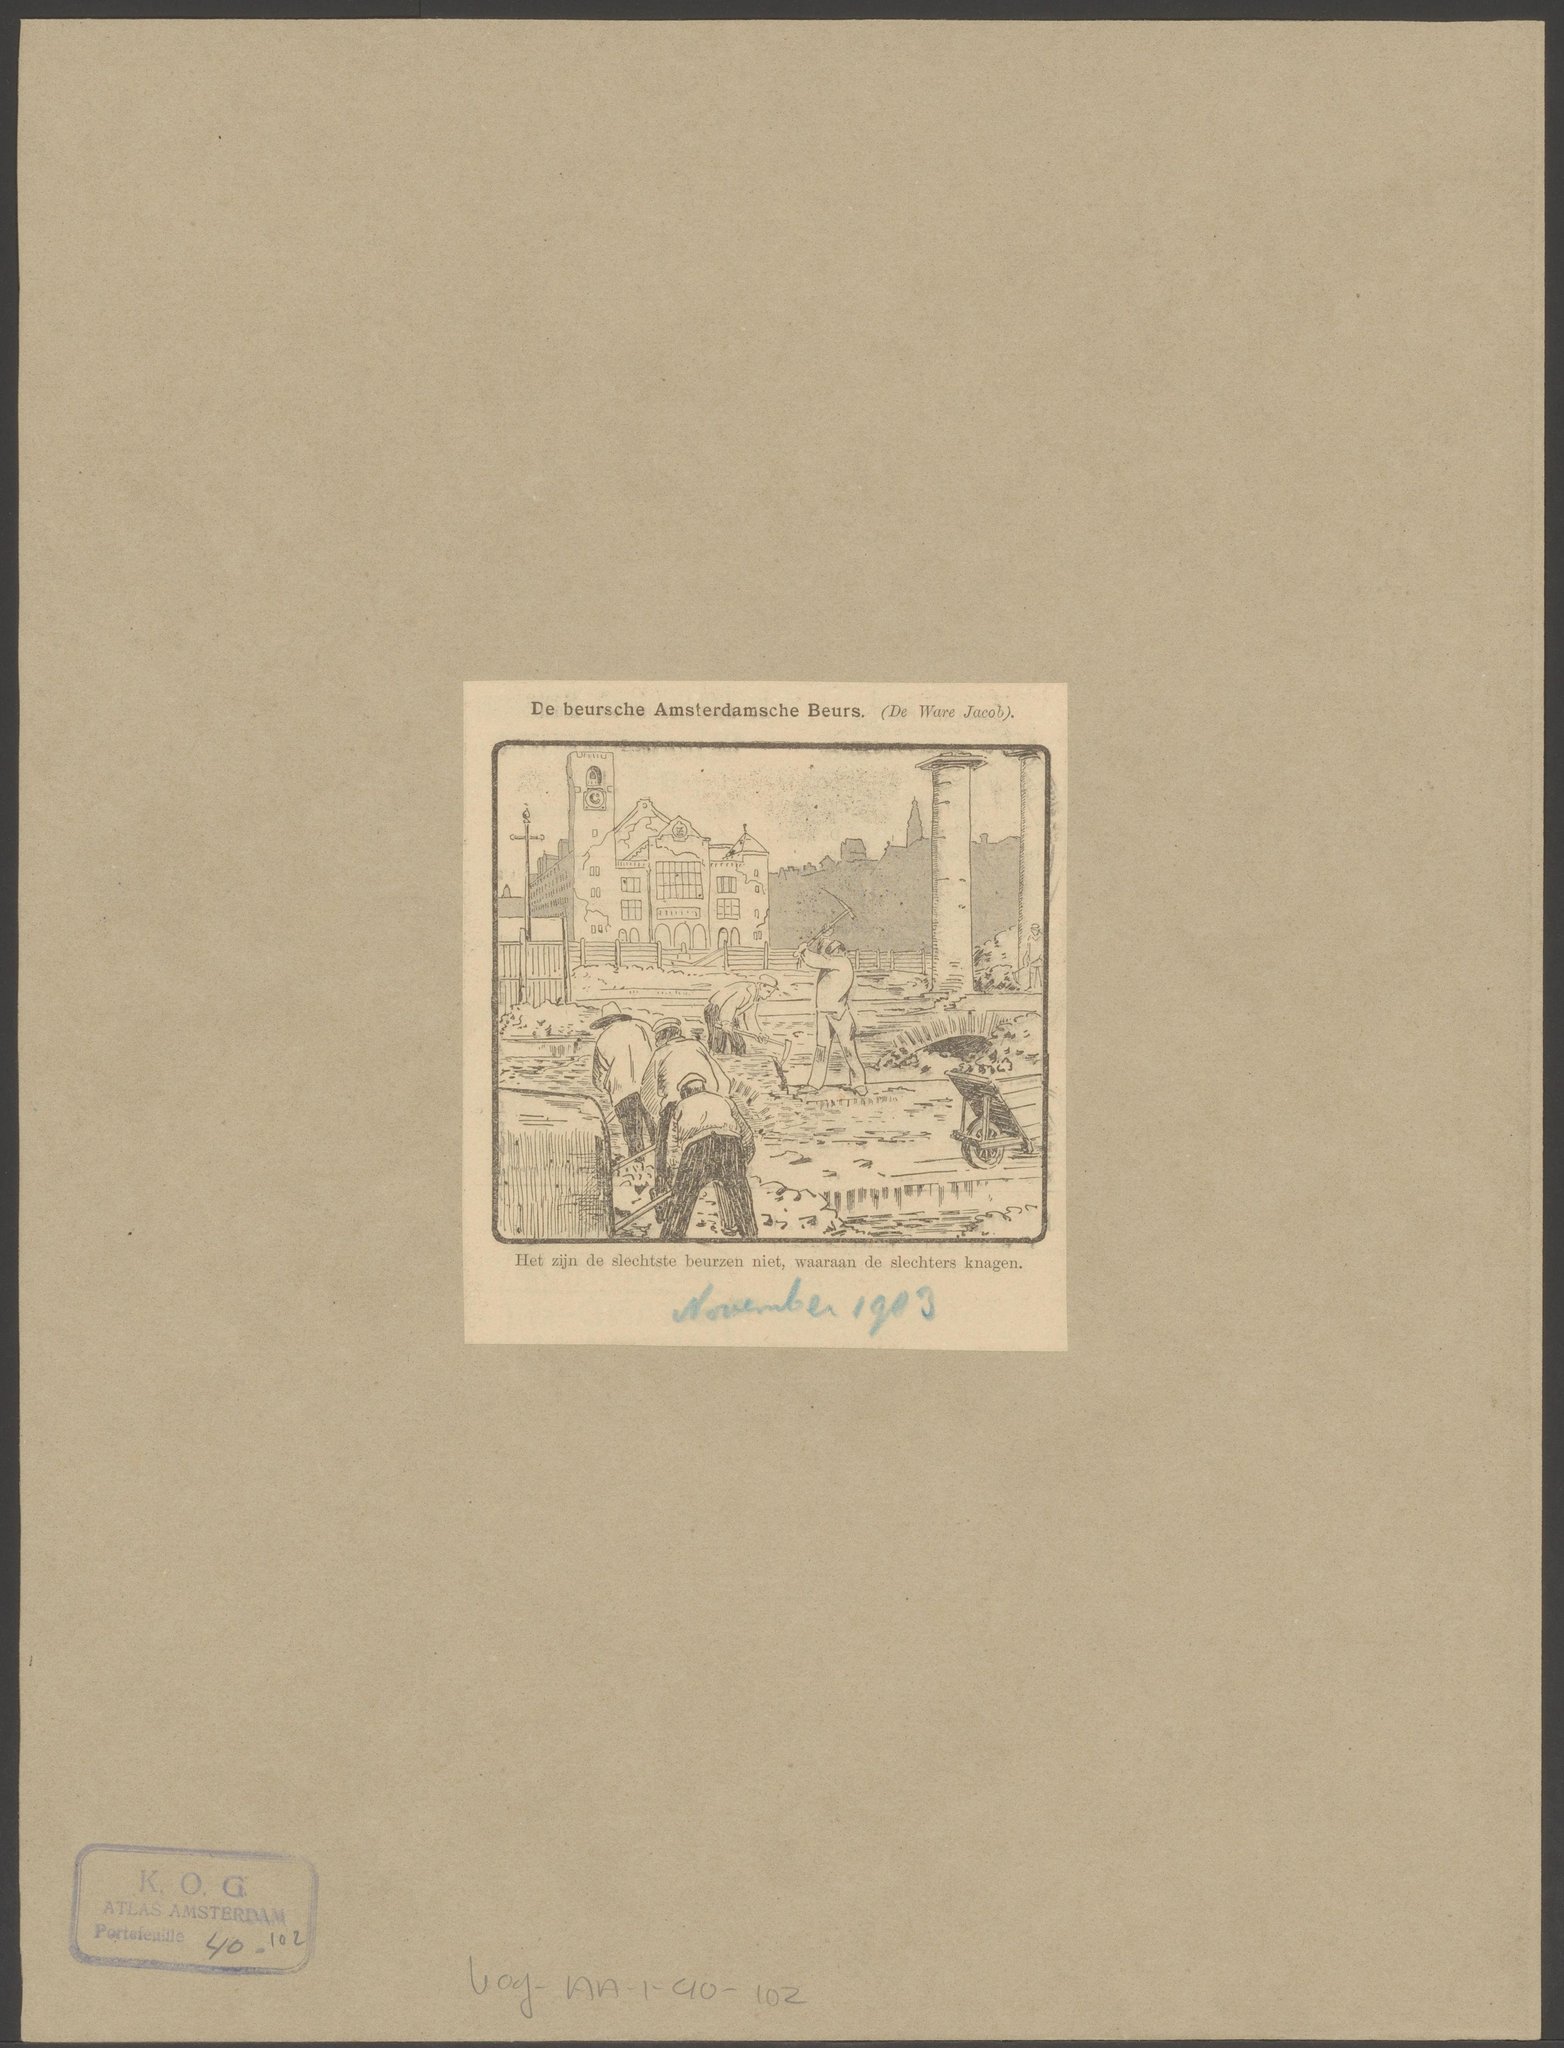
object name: photomechanical print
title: Arbeiders aan het werk bij de afbraak van de Beurs van Zocher te Amsterdam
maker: Anonymous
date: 1903-1911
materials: paper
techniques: letterpress printing, line block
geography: netherlands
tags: stock exchange, stock-market, demolition of building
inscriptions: collector's mark: Lugt 1641b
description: Onderwerpsrubriek binnen de Atlas Amsterdam: Handel en Zeevaart: Hulpbeurs op de Dam en Beurs (Dam).